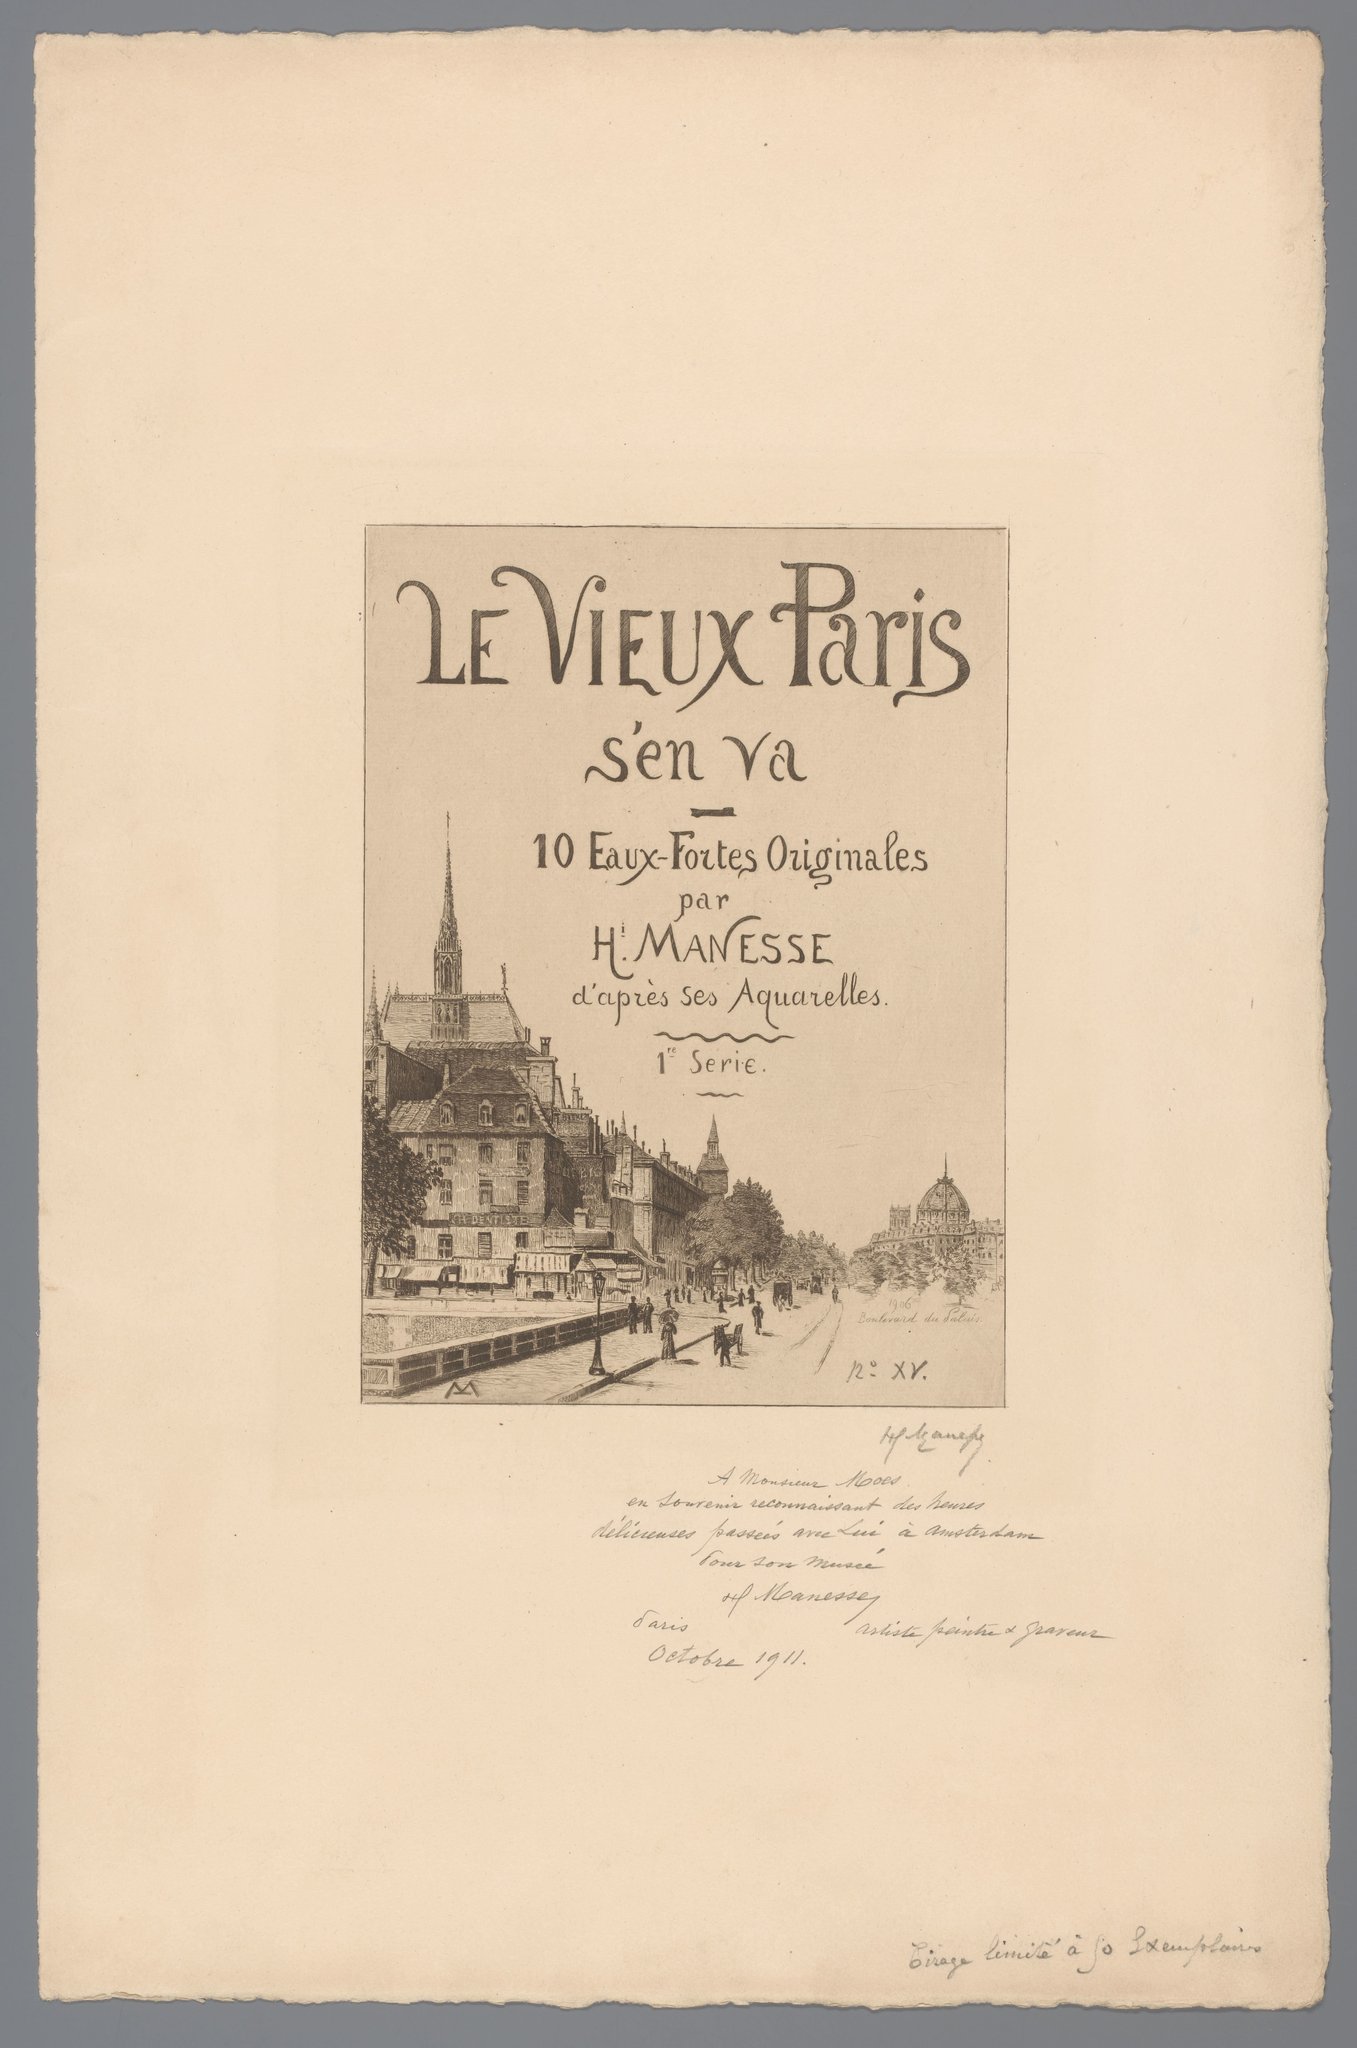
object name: print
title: Titelprent met zicht op Parijs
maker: henri manesse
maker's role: print maker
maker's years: 1854-1940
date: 1906-1911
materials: paper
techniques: etching, intaglio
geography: france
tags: city-view in general; 'veduta', bridge in city across river, canal, etc., paris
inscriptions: collector's mark: Lugt 2228, dedication: ‘A Monsieur Moes en souvenir reconnaissant des heures délicieuses passées avec Lui à Amsterdam [...]our son musée/ H Manesse artiste peintre & graveur/ Paris/ Octobre 1911’, edition: ‘Tirage limité à 50 [?] Exemplaires’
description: Dit is de eerste serie uit een prentreeks die uit minstens elf series bestaat.